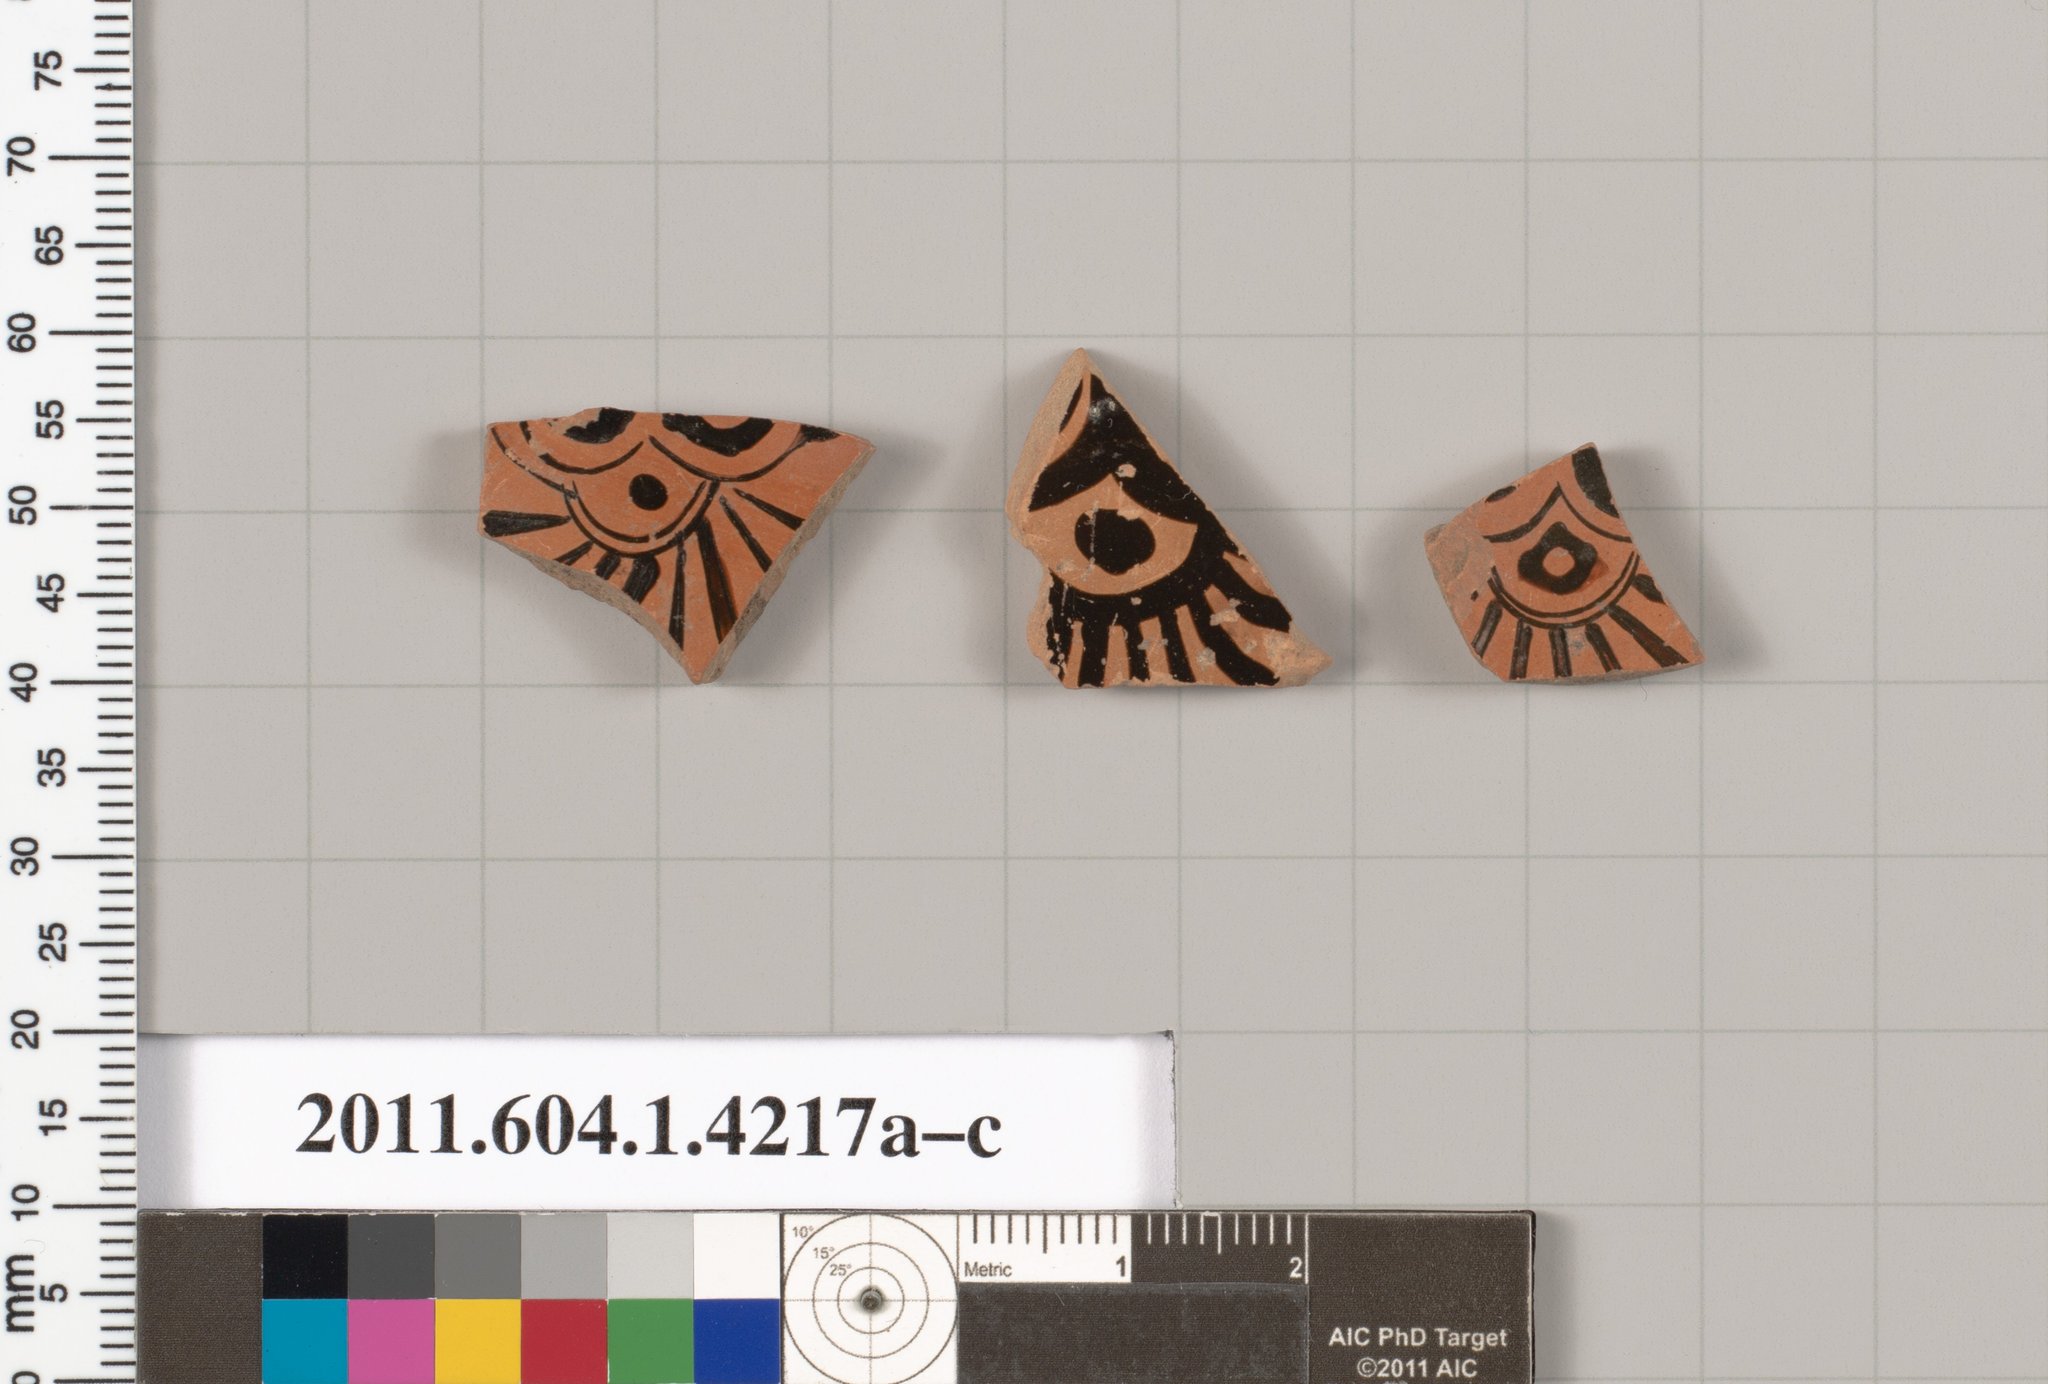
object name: kylix fragment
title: Terracotta fragments of kylikes (drinking cups)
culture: greek, attic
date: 500-451 BCE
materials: terracotta